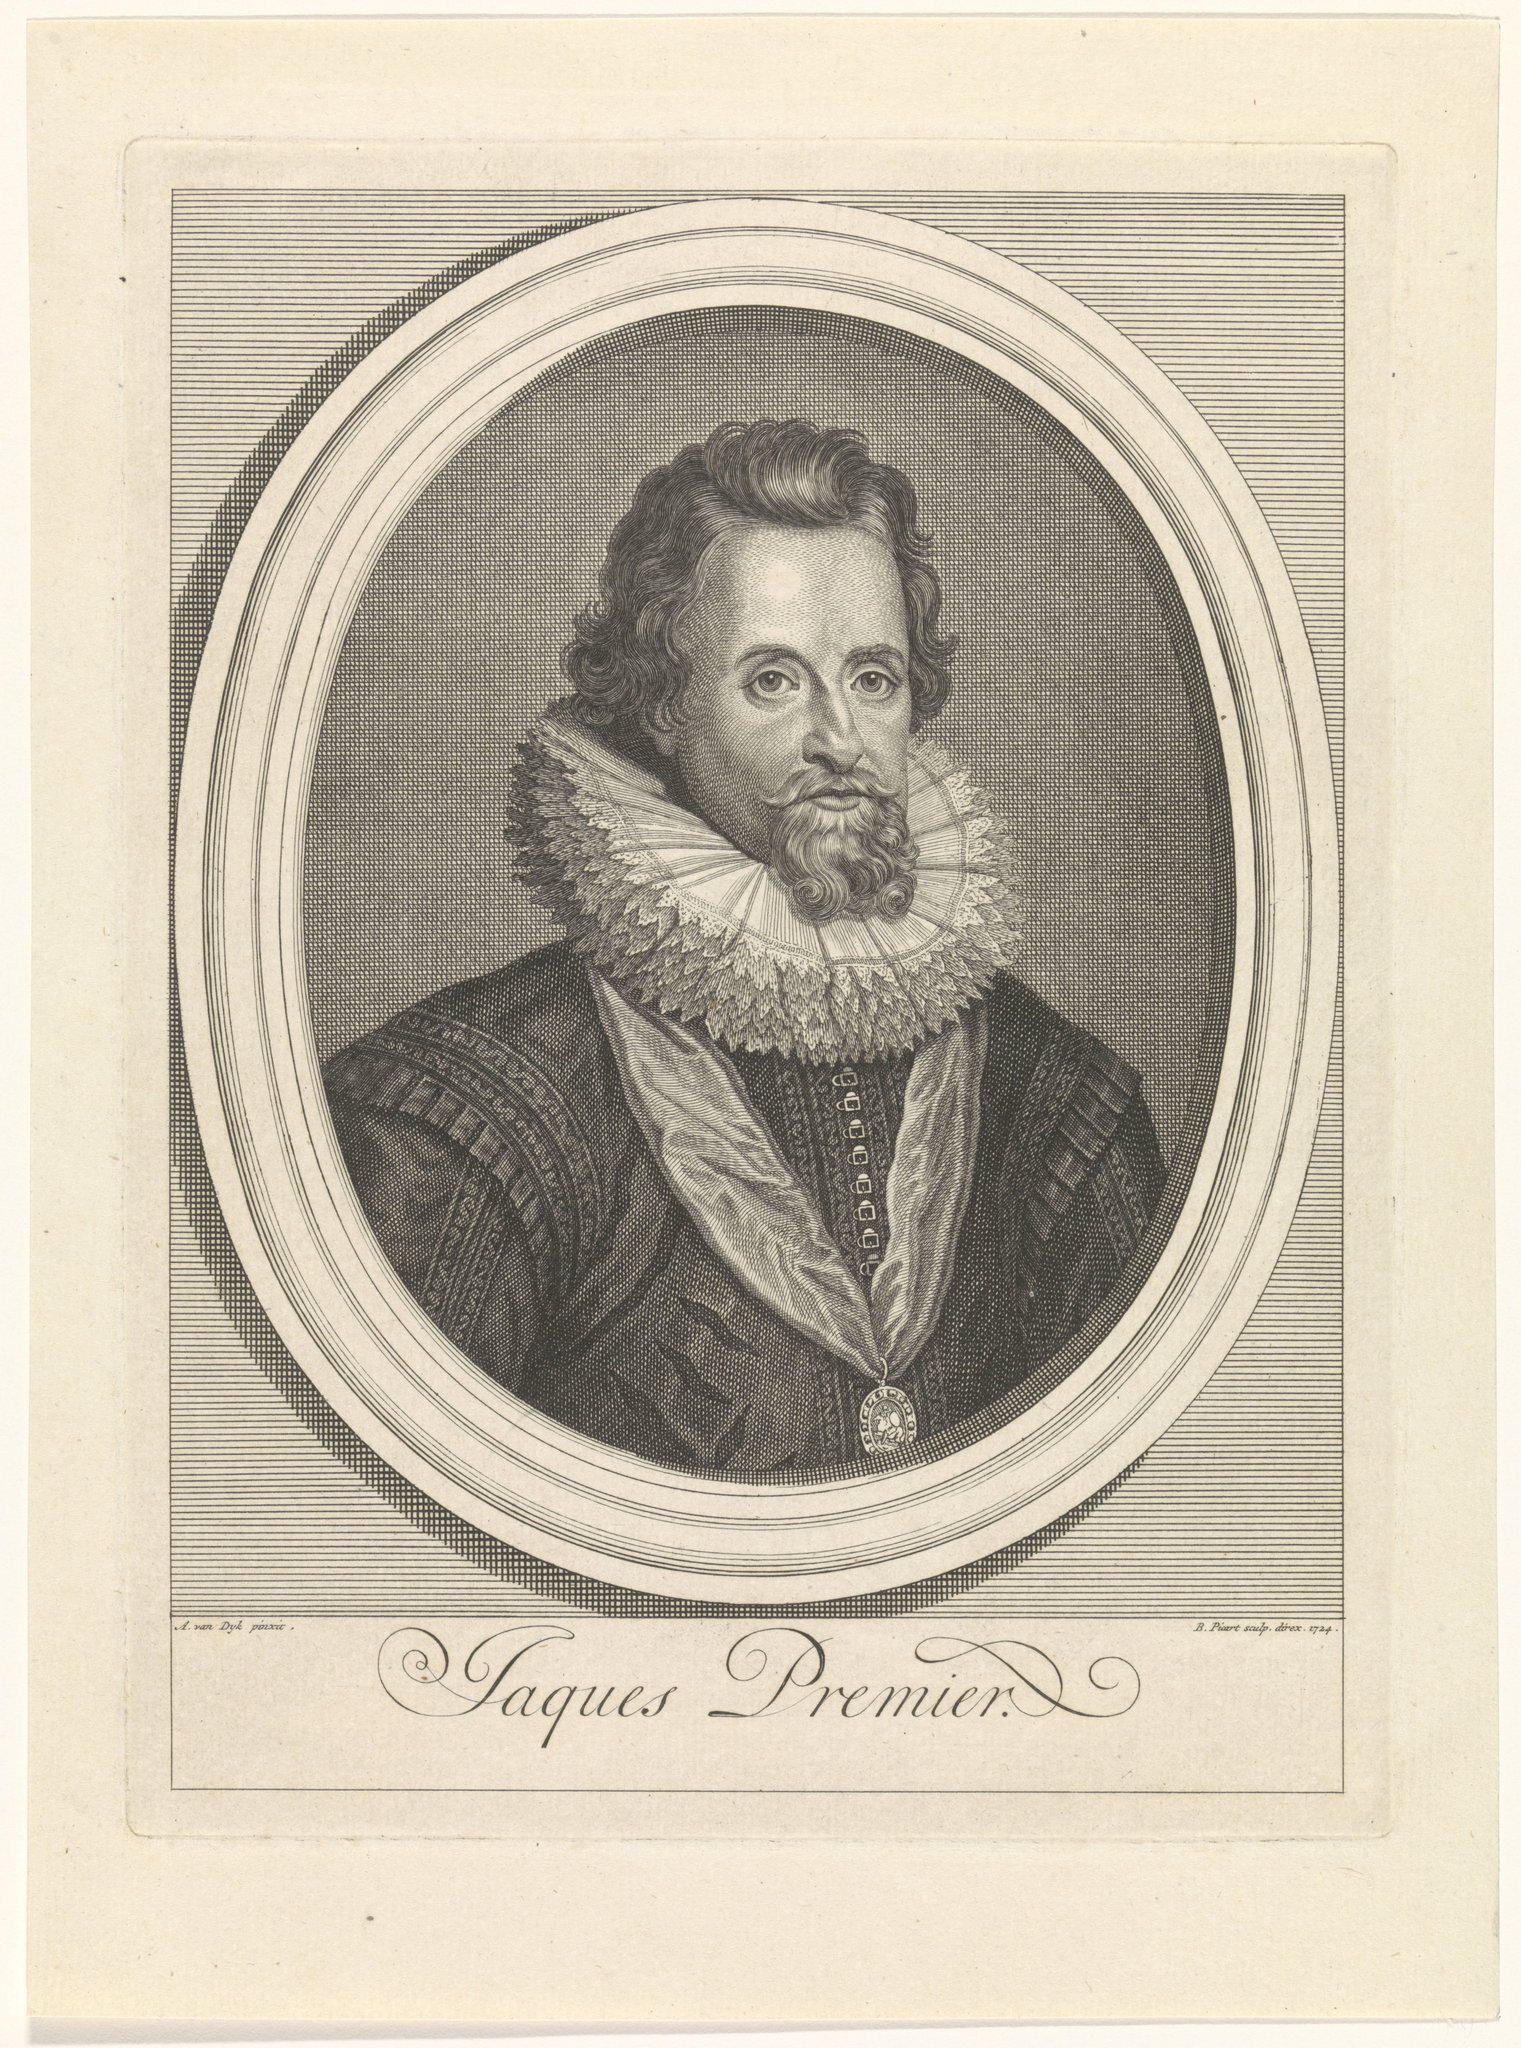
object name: print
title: Portret van Jacobus I, koning van Engeland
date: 1724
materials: paper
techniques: engraving, etching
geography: amsterdam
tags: jacobus i (koning van engeland)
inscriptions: collector's mark: Lugt 2228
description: Prent als illustratie gebruikt in: Burnet, Gilbert. Histoire des dernières révolutions d'Angleterre, deel I. Den Haag: Jean Neaulme, 1725.